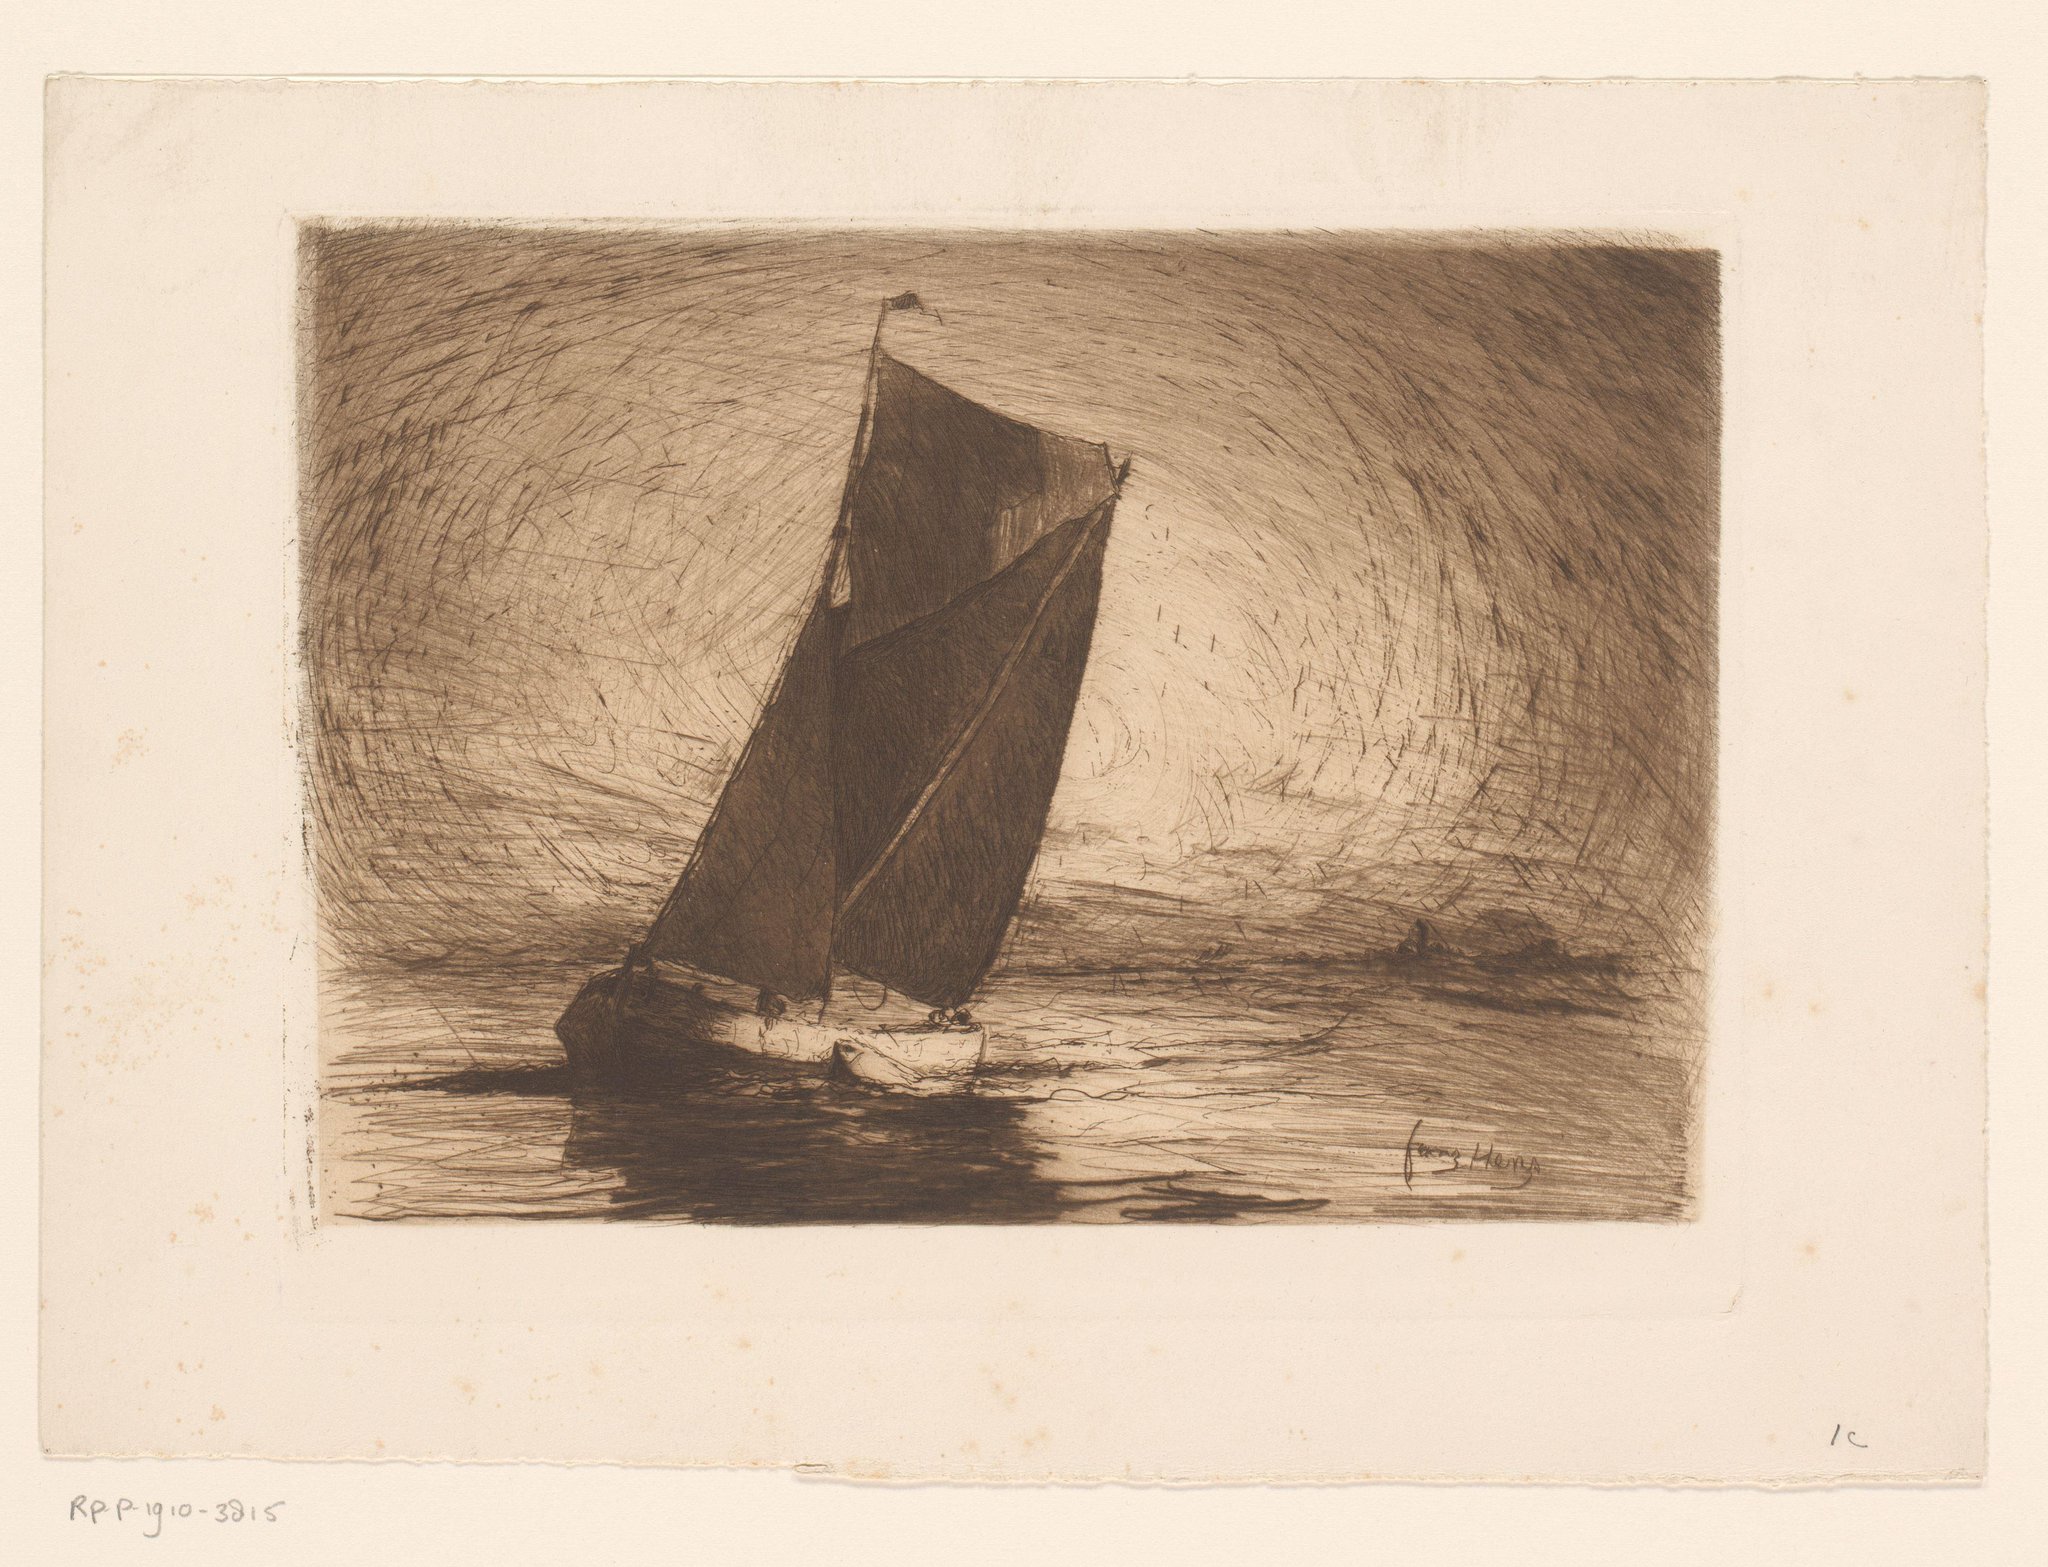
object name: print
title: Zeilend schip met kustlijn op de achtergrond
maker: frans hens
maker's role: print maker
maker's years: 1856-1928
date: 1866-1910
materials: paper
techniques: drypoint, etching, intaglio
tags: sailing-ship, sailing-boat, landscapes with waters, waterscapes, seascapes (in the temperate zone)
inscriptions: collector's mark: Lugt 2228